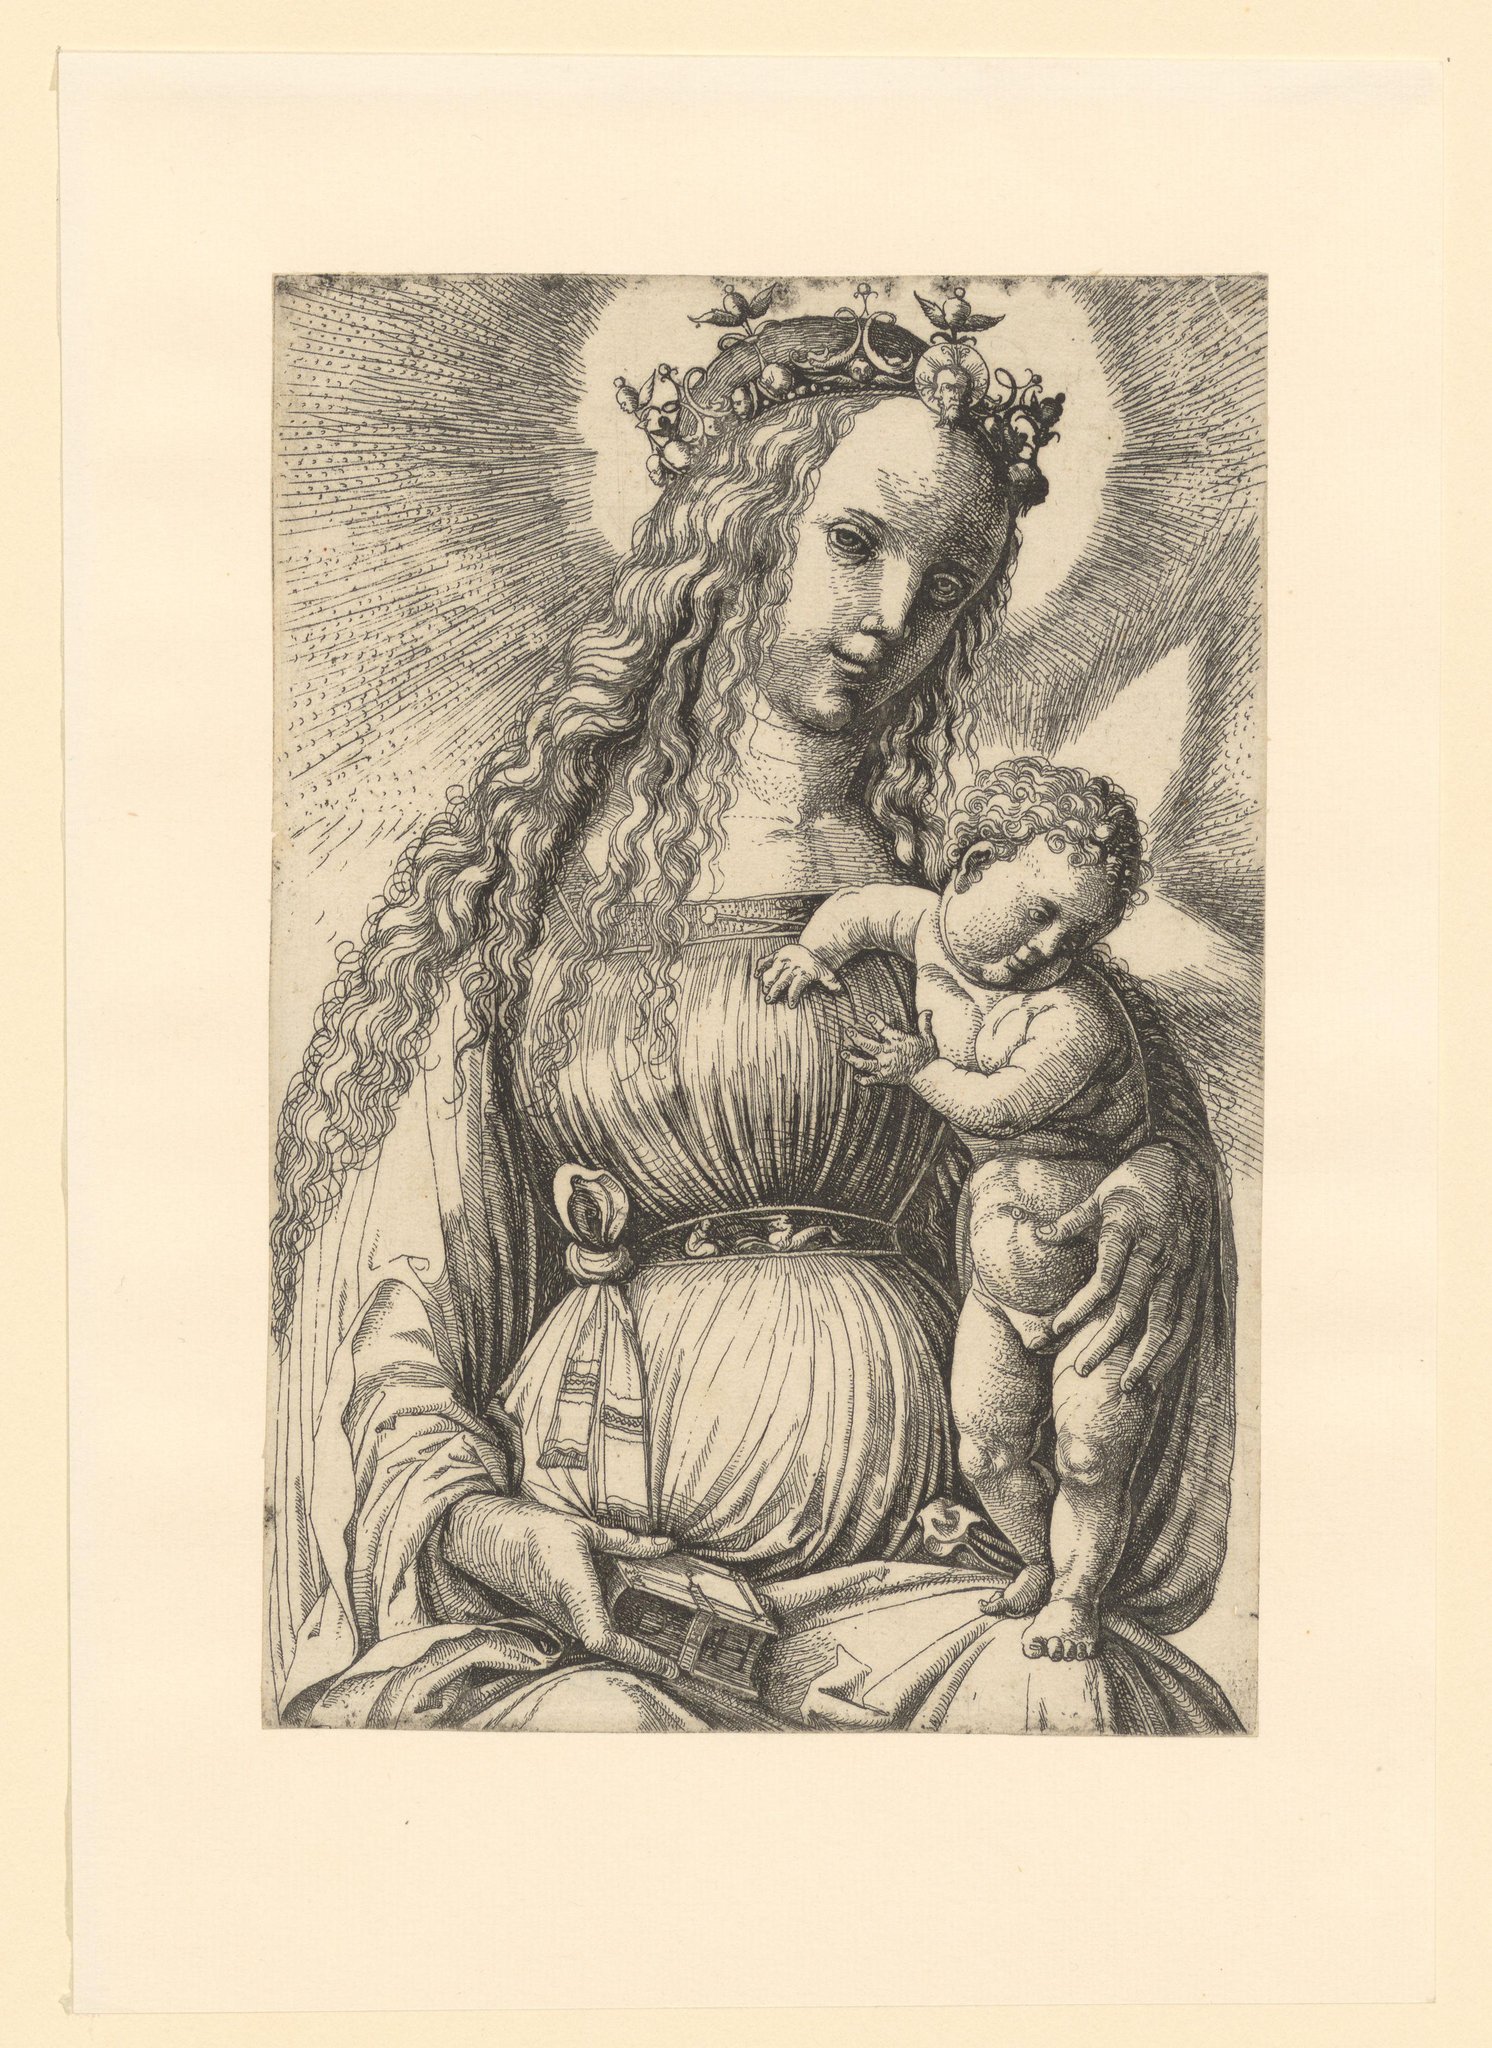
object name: print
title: Maria met kind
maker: daniel hopfer (i)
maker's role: print maker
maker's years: 1470-1536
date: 1500-1536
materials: paper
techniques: etching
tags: mary sitting or enthroned, the christ-child standing on her knee (christ-child to mary's left)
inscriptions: collector's mark: Lugt 2228